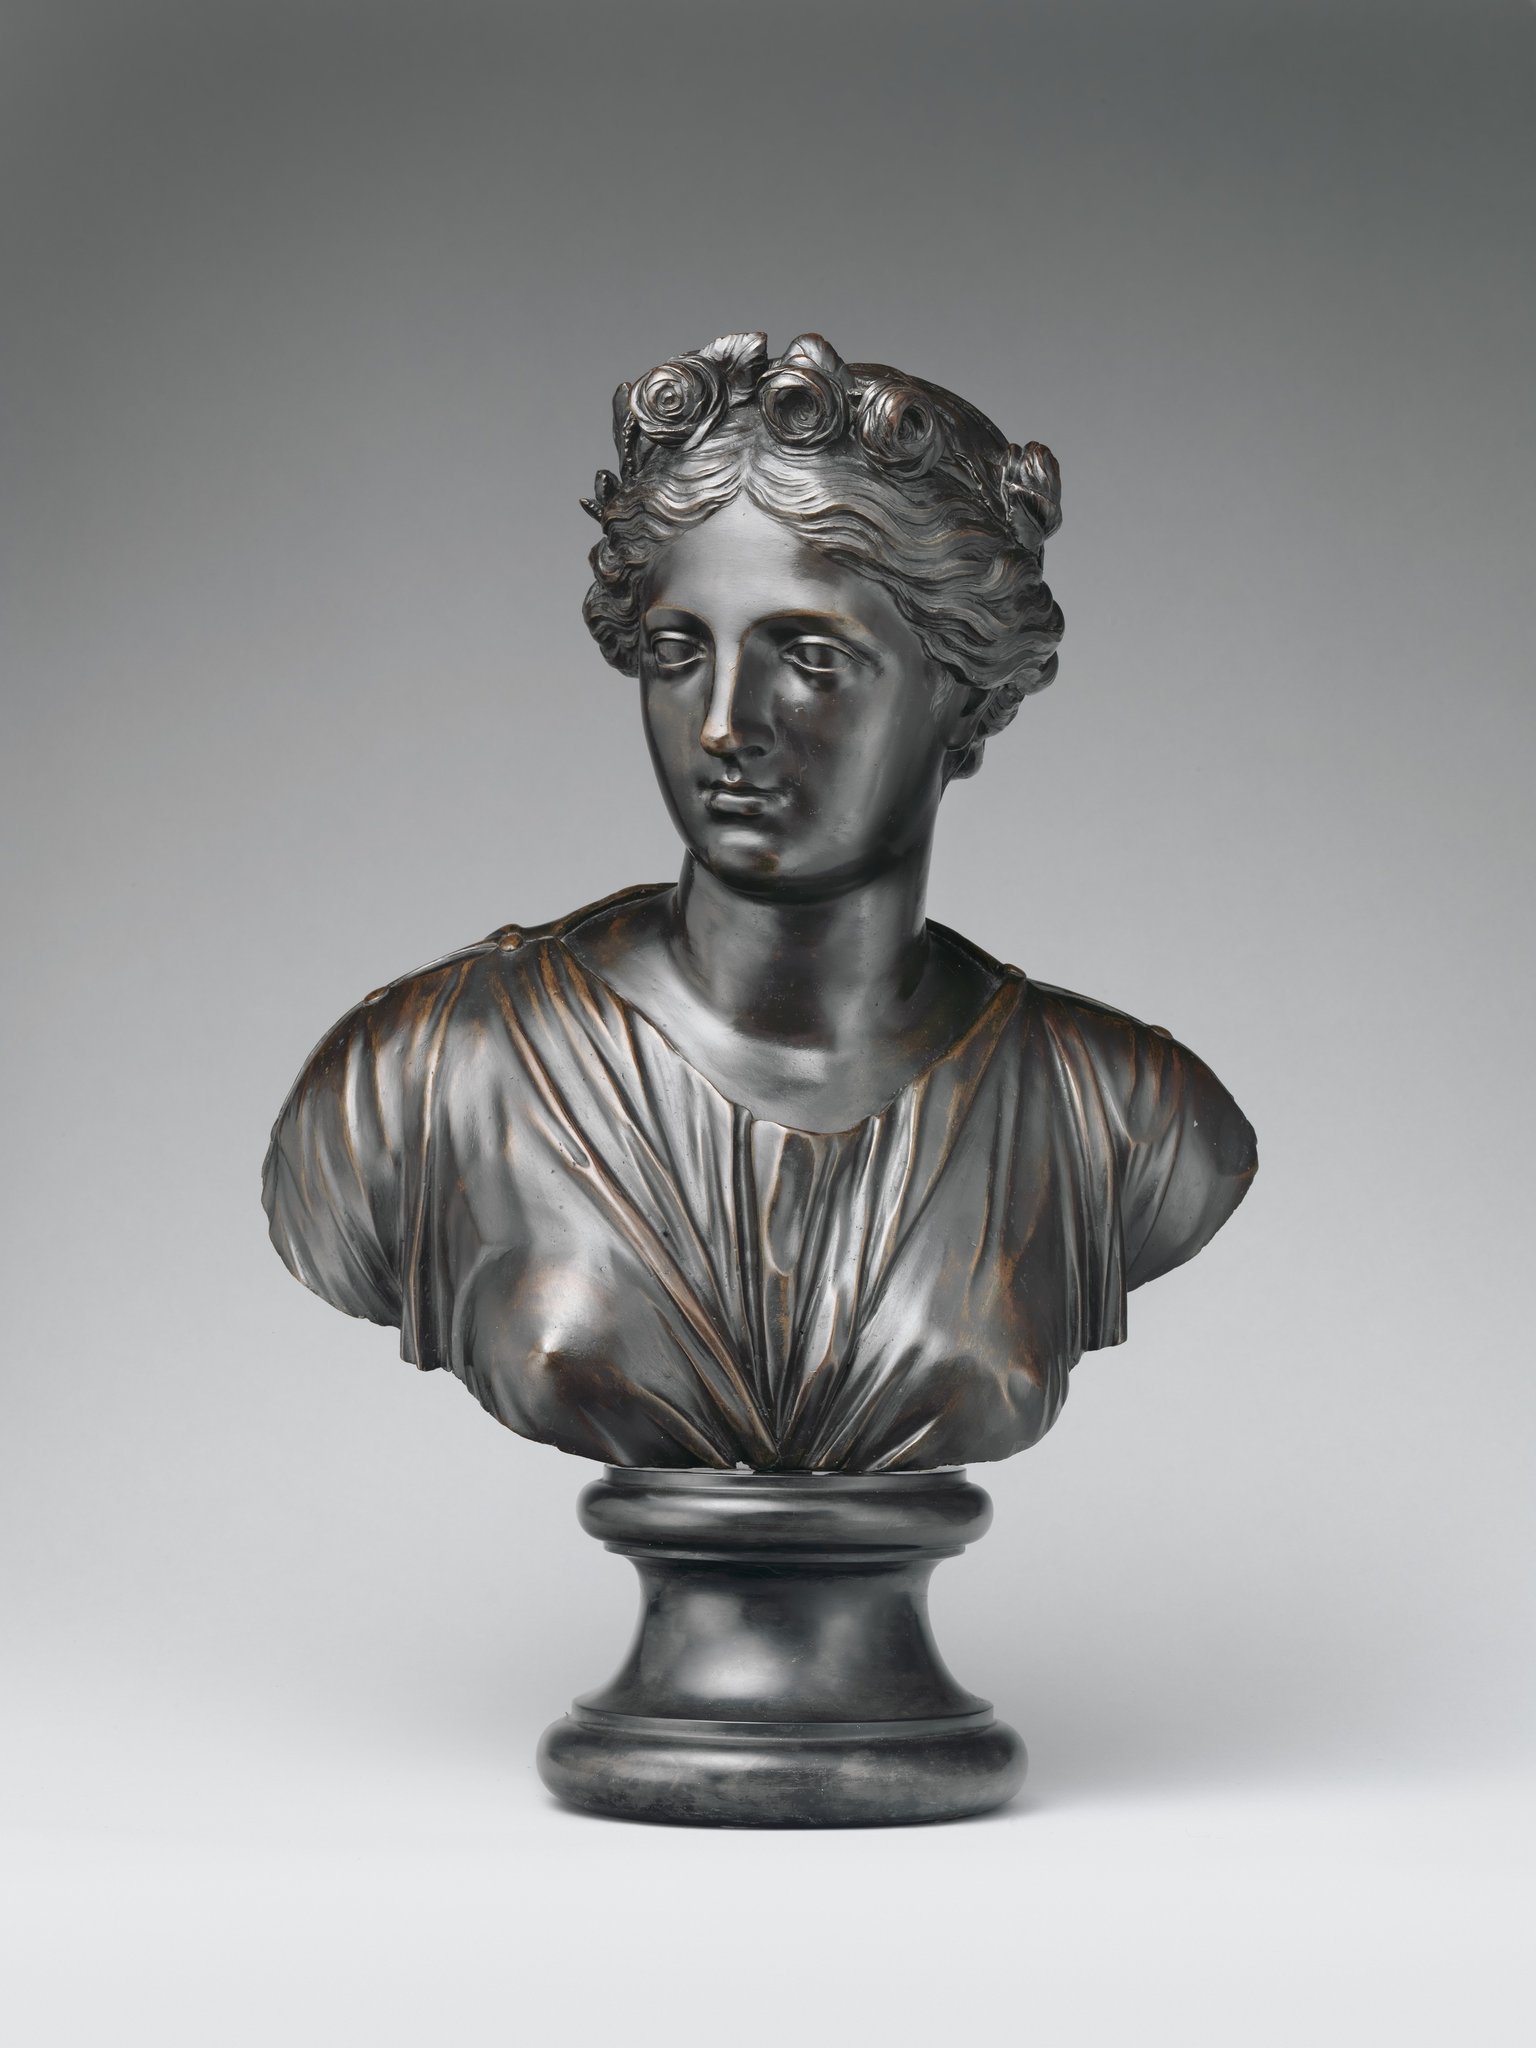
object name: bust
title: Erato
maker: françois girardon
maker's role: artist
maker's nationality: french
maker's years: 1628-1715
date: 1680-1700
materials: bronze, marble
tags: goddess